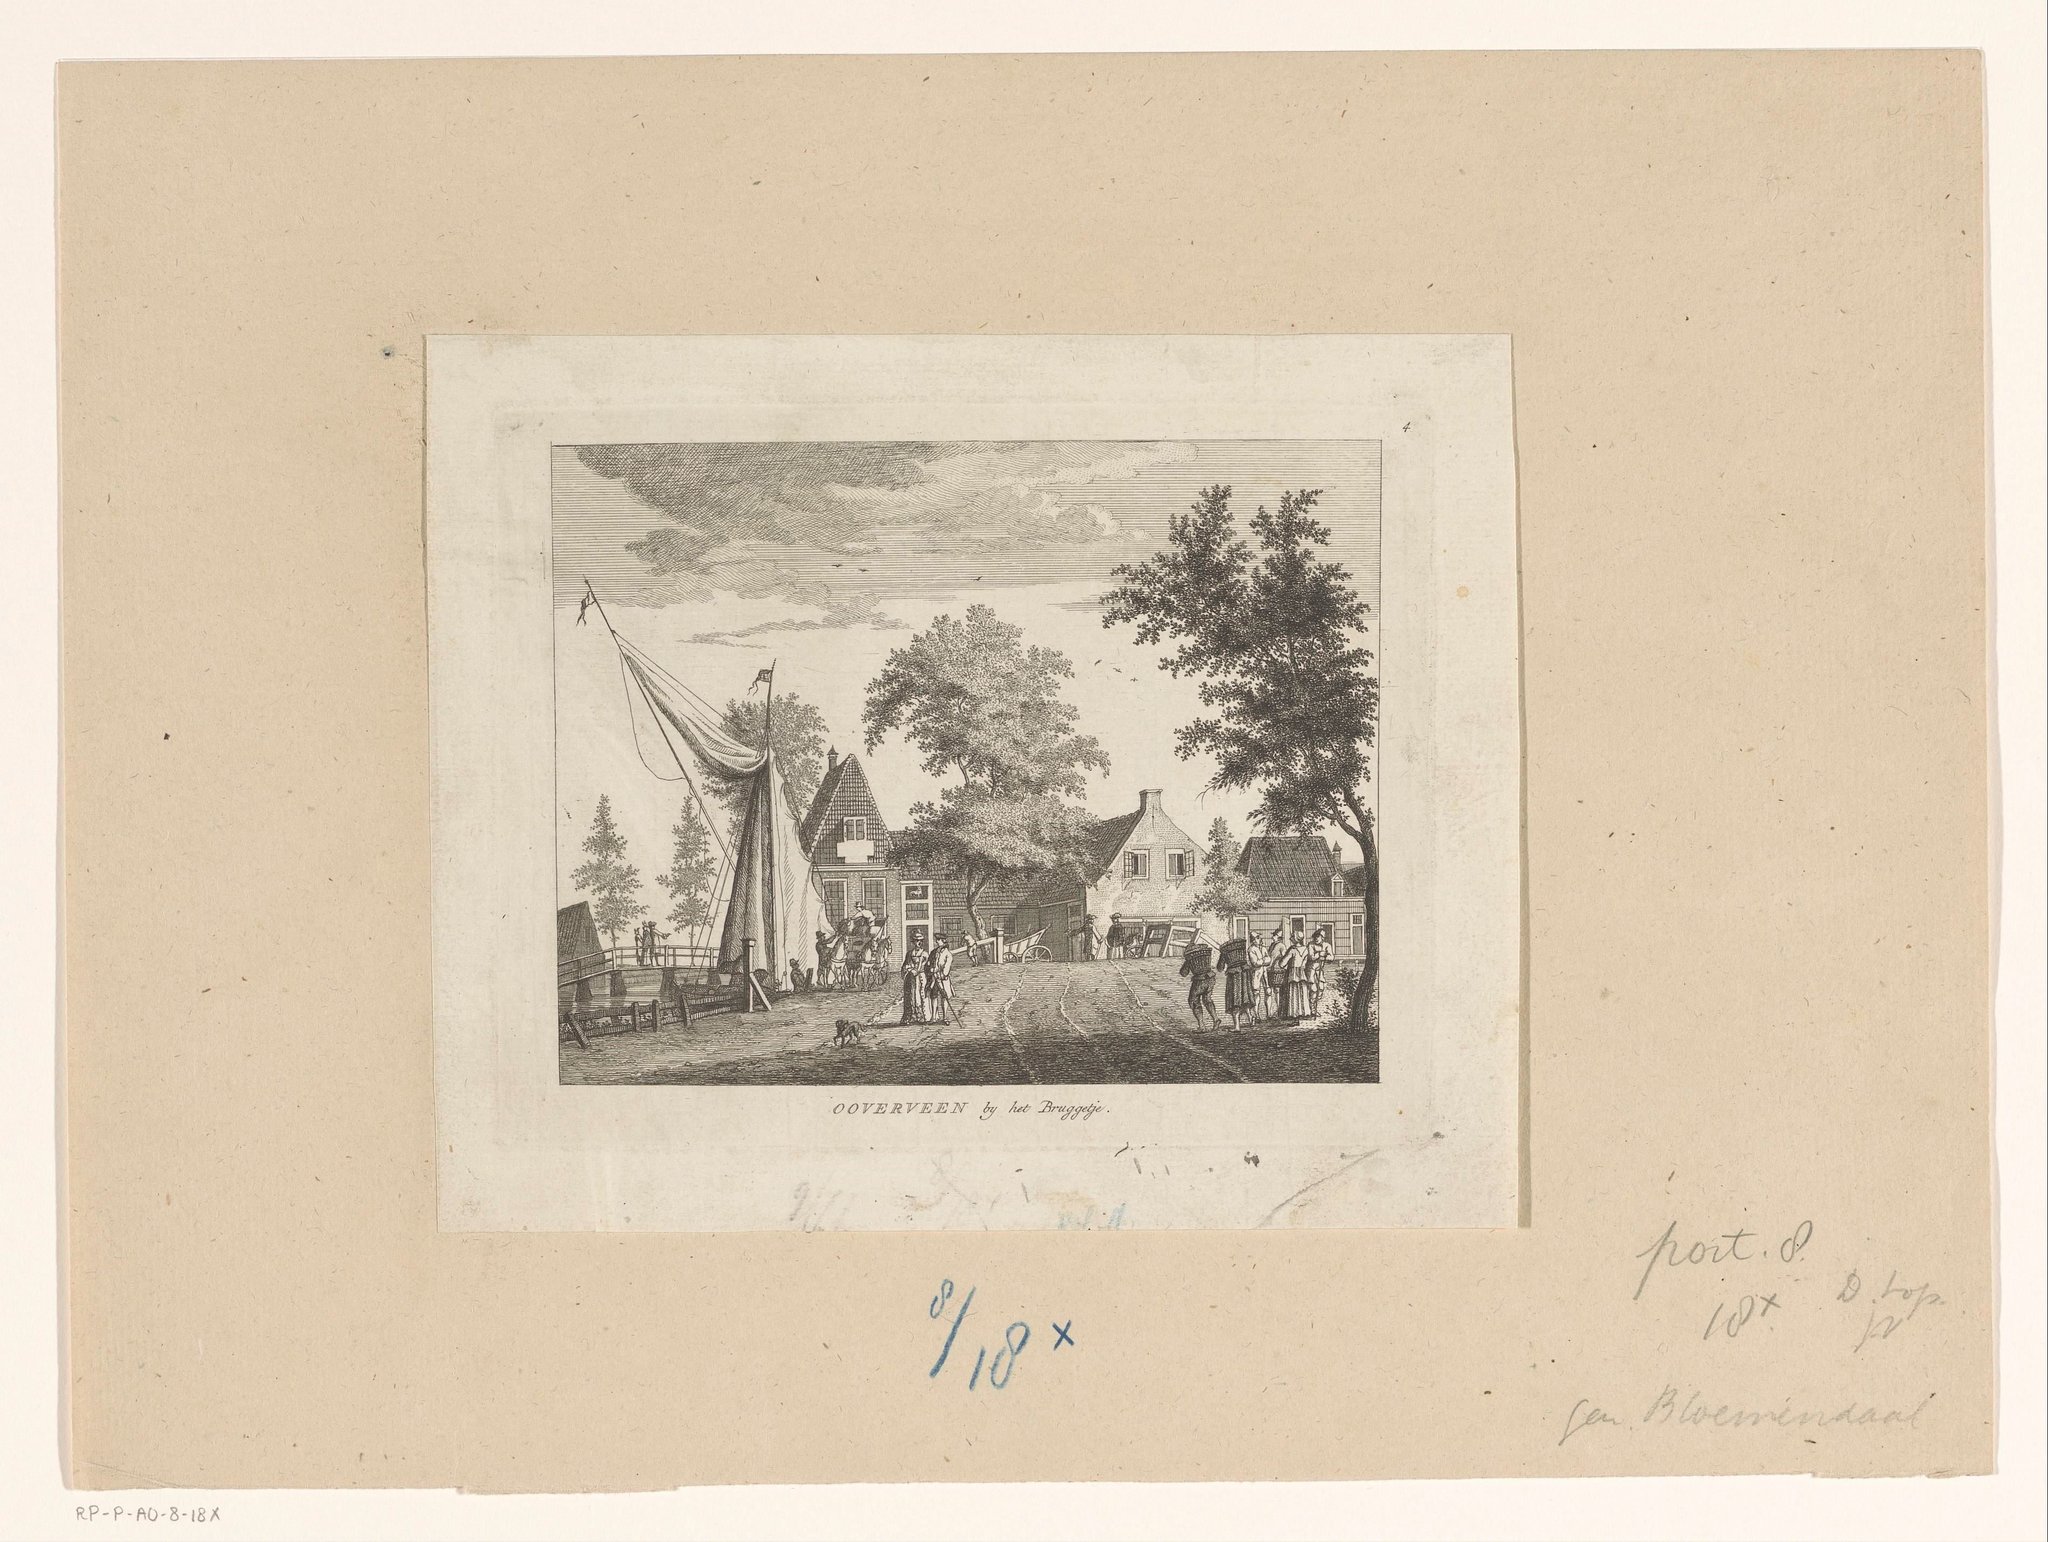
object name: print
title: Gezicht op het dorp Overveen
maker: Anonymous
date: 1760-1800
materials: paper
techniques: engraving, etching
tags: sailing-ship, sailing-boat, bridge, public road in village (+ city(-scape) with figures, staffage)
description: Deze prent is eerst verschenen in een reeks van twaalf prenten uitgegeven door Pierre Fouquet junior in de tweede helft van de achttiende eeuw. Deze reeks bestond uit prenten van: Slot Zuylen (2x), het dorp Maarssen (3x), Deil, de Laatste Stuiver bij Houten, Het Zwarte Varken bij Maarsseveen, Oud Rome bij Haarlem, Overveen, Zoelen en de Hommelbrug bij Oudenrijn. Later zijn deze prenten gebruikt in: Gezigten van voornaame Hollandsche dorpen. Amsterdam: Evert Maaskamp, s.a. [ca. 1775-1800].